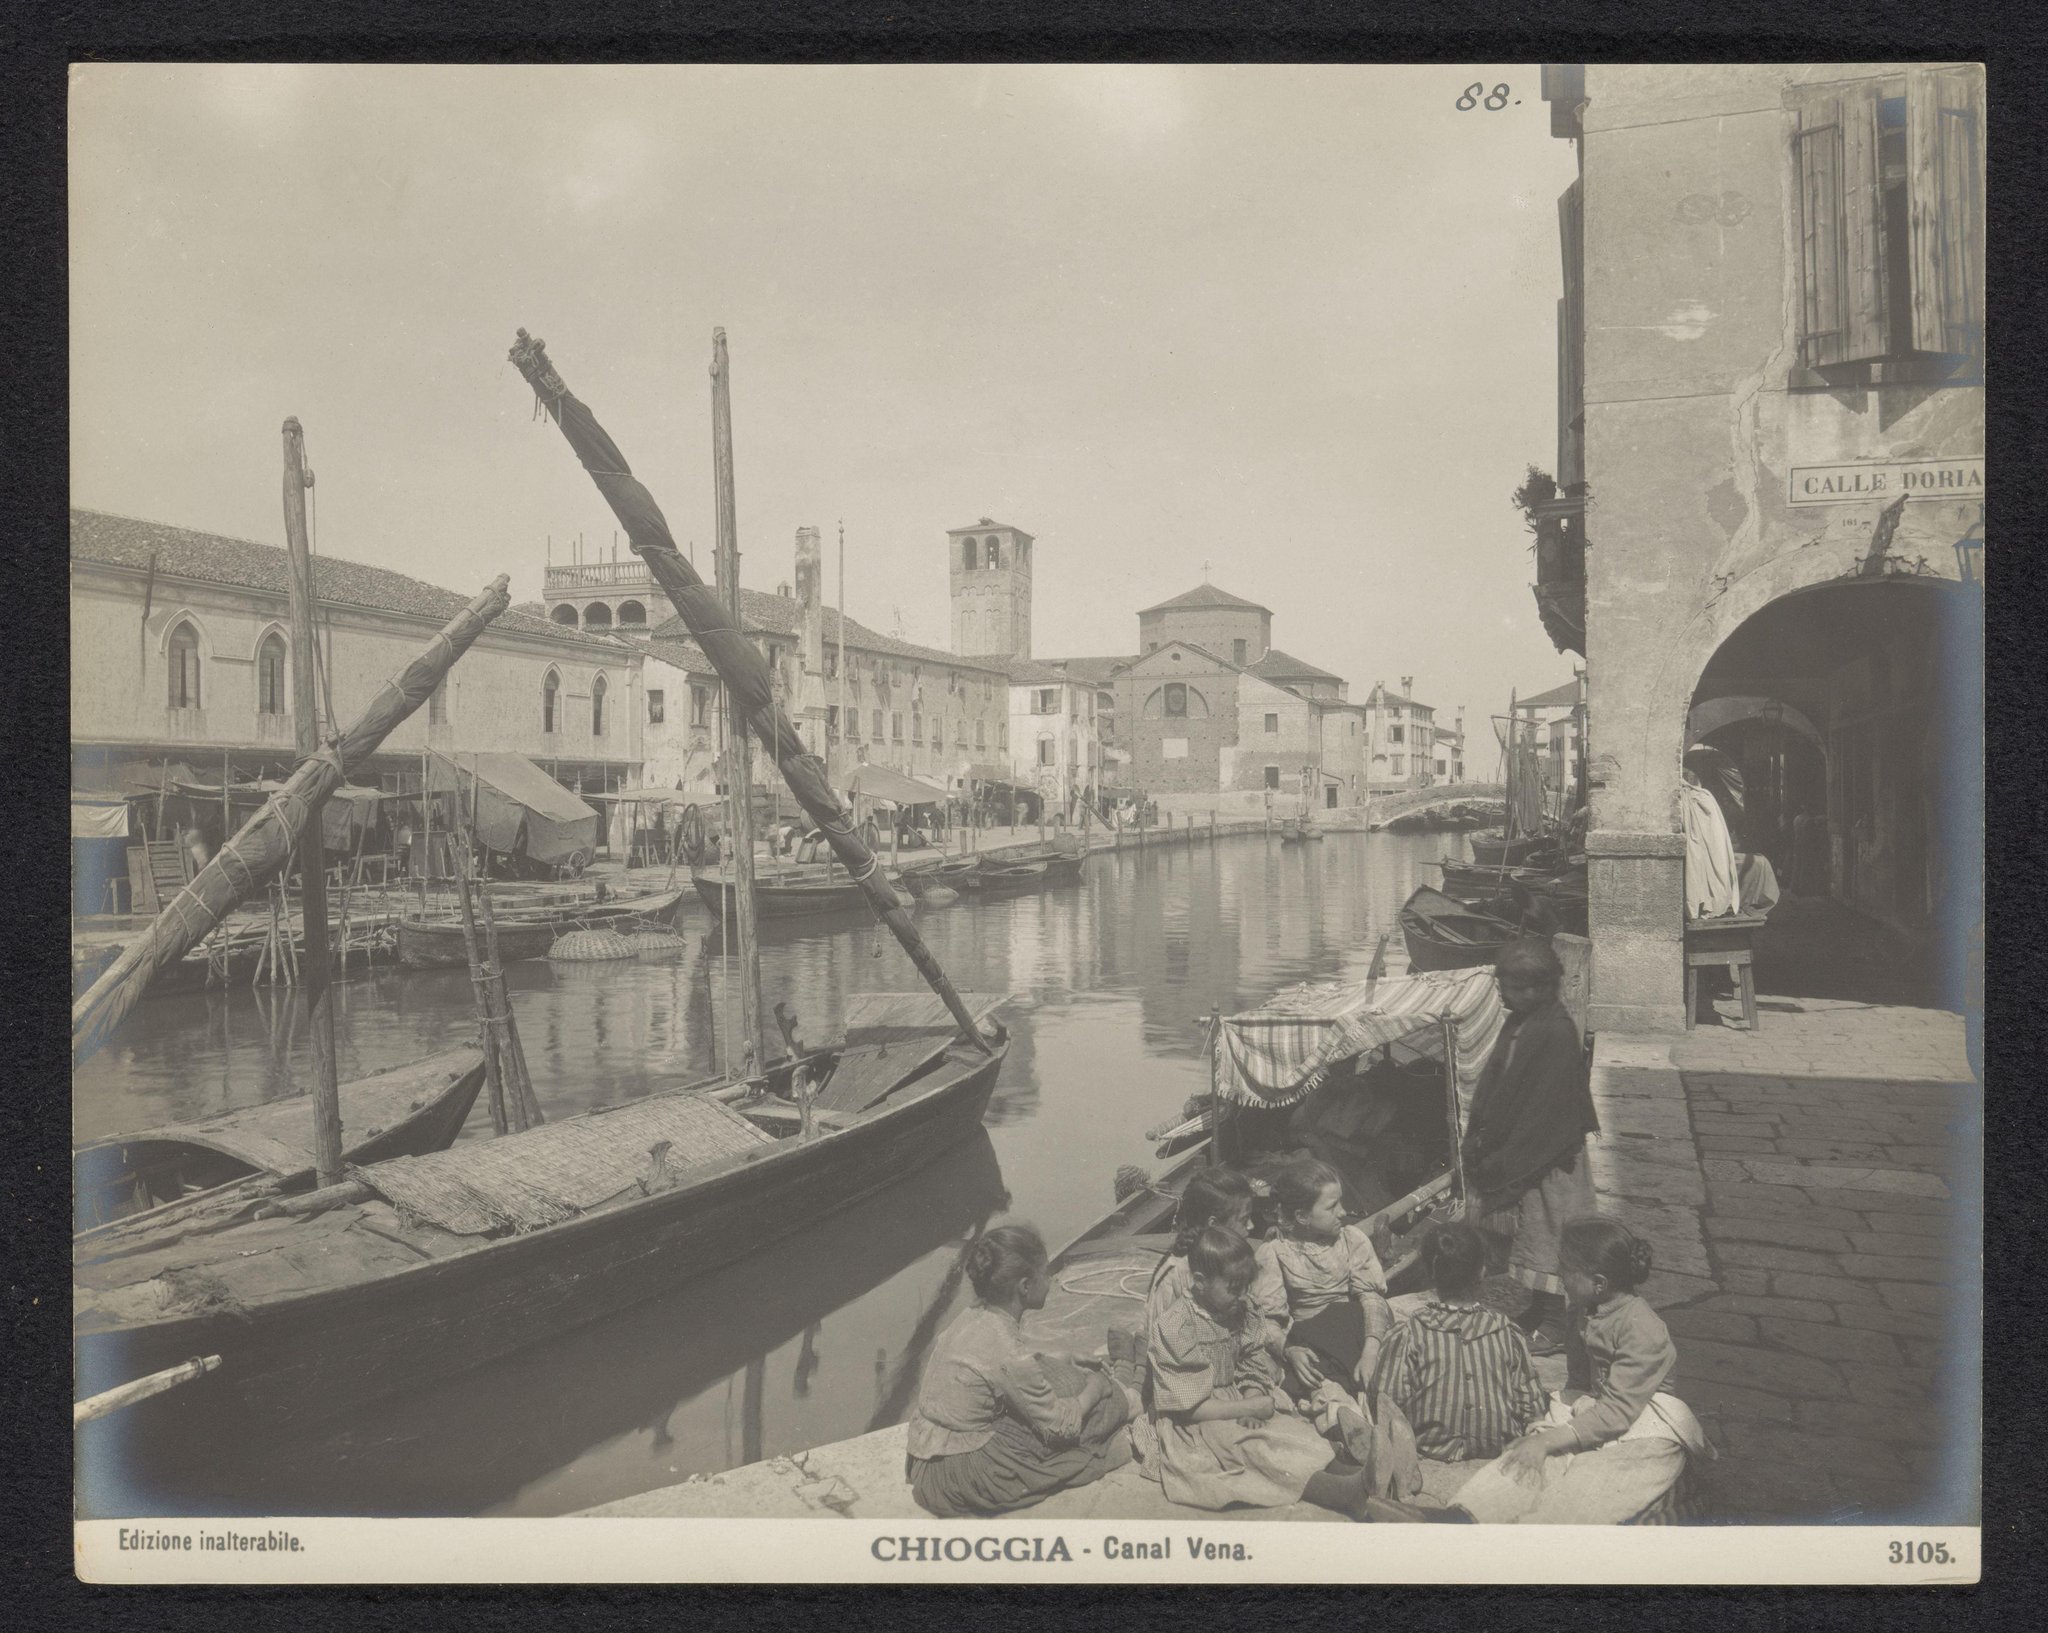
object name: photograph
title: Chioggia - Canal Vena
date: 1900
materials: cardboard, photographic support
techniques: gelatin silver print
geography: chioggia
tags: child, canal, quay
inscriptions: number: ‘3105.’, number: ‘88.’